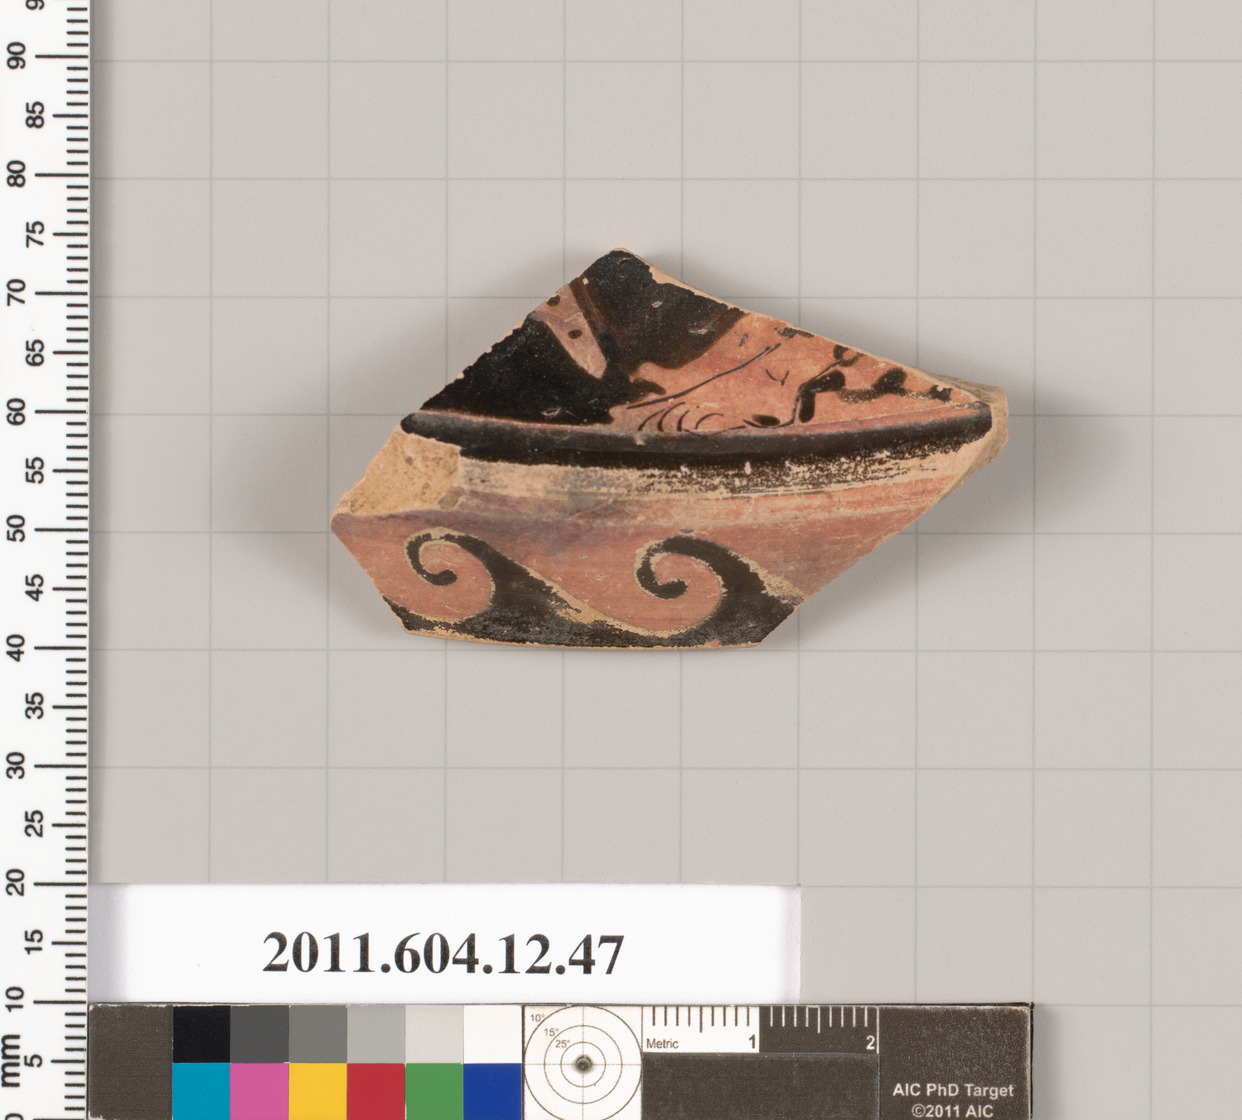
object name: lekanis fragment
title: Terracotta fragment of a lekanis (dish)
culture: greek, paestan or south italian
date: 400-301 BCE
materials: terracotta